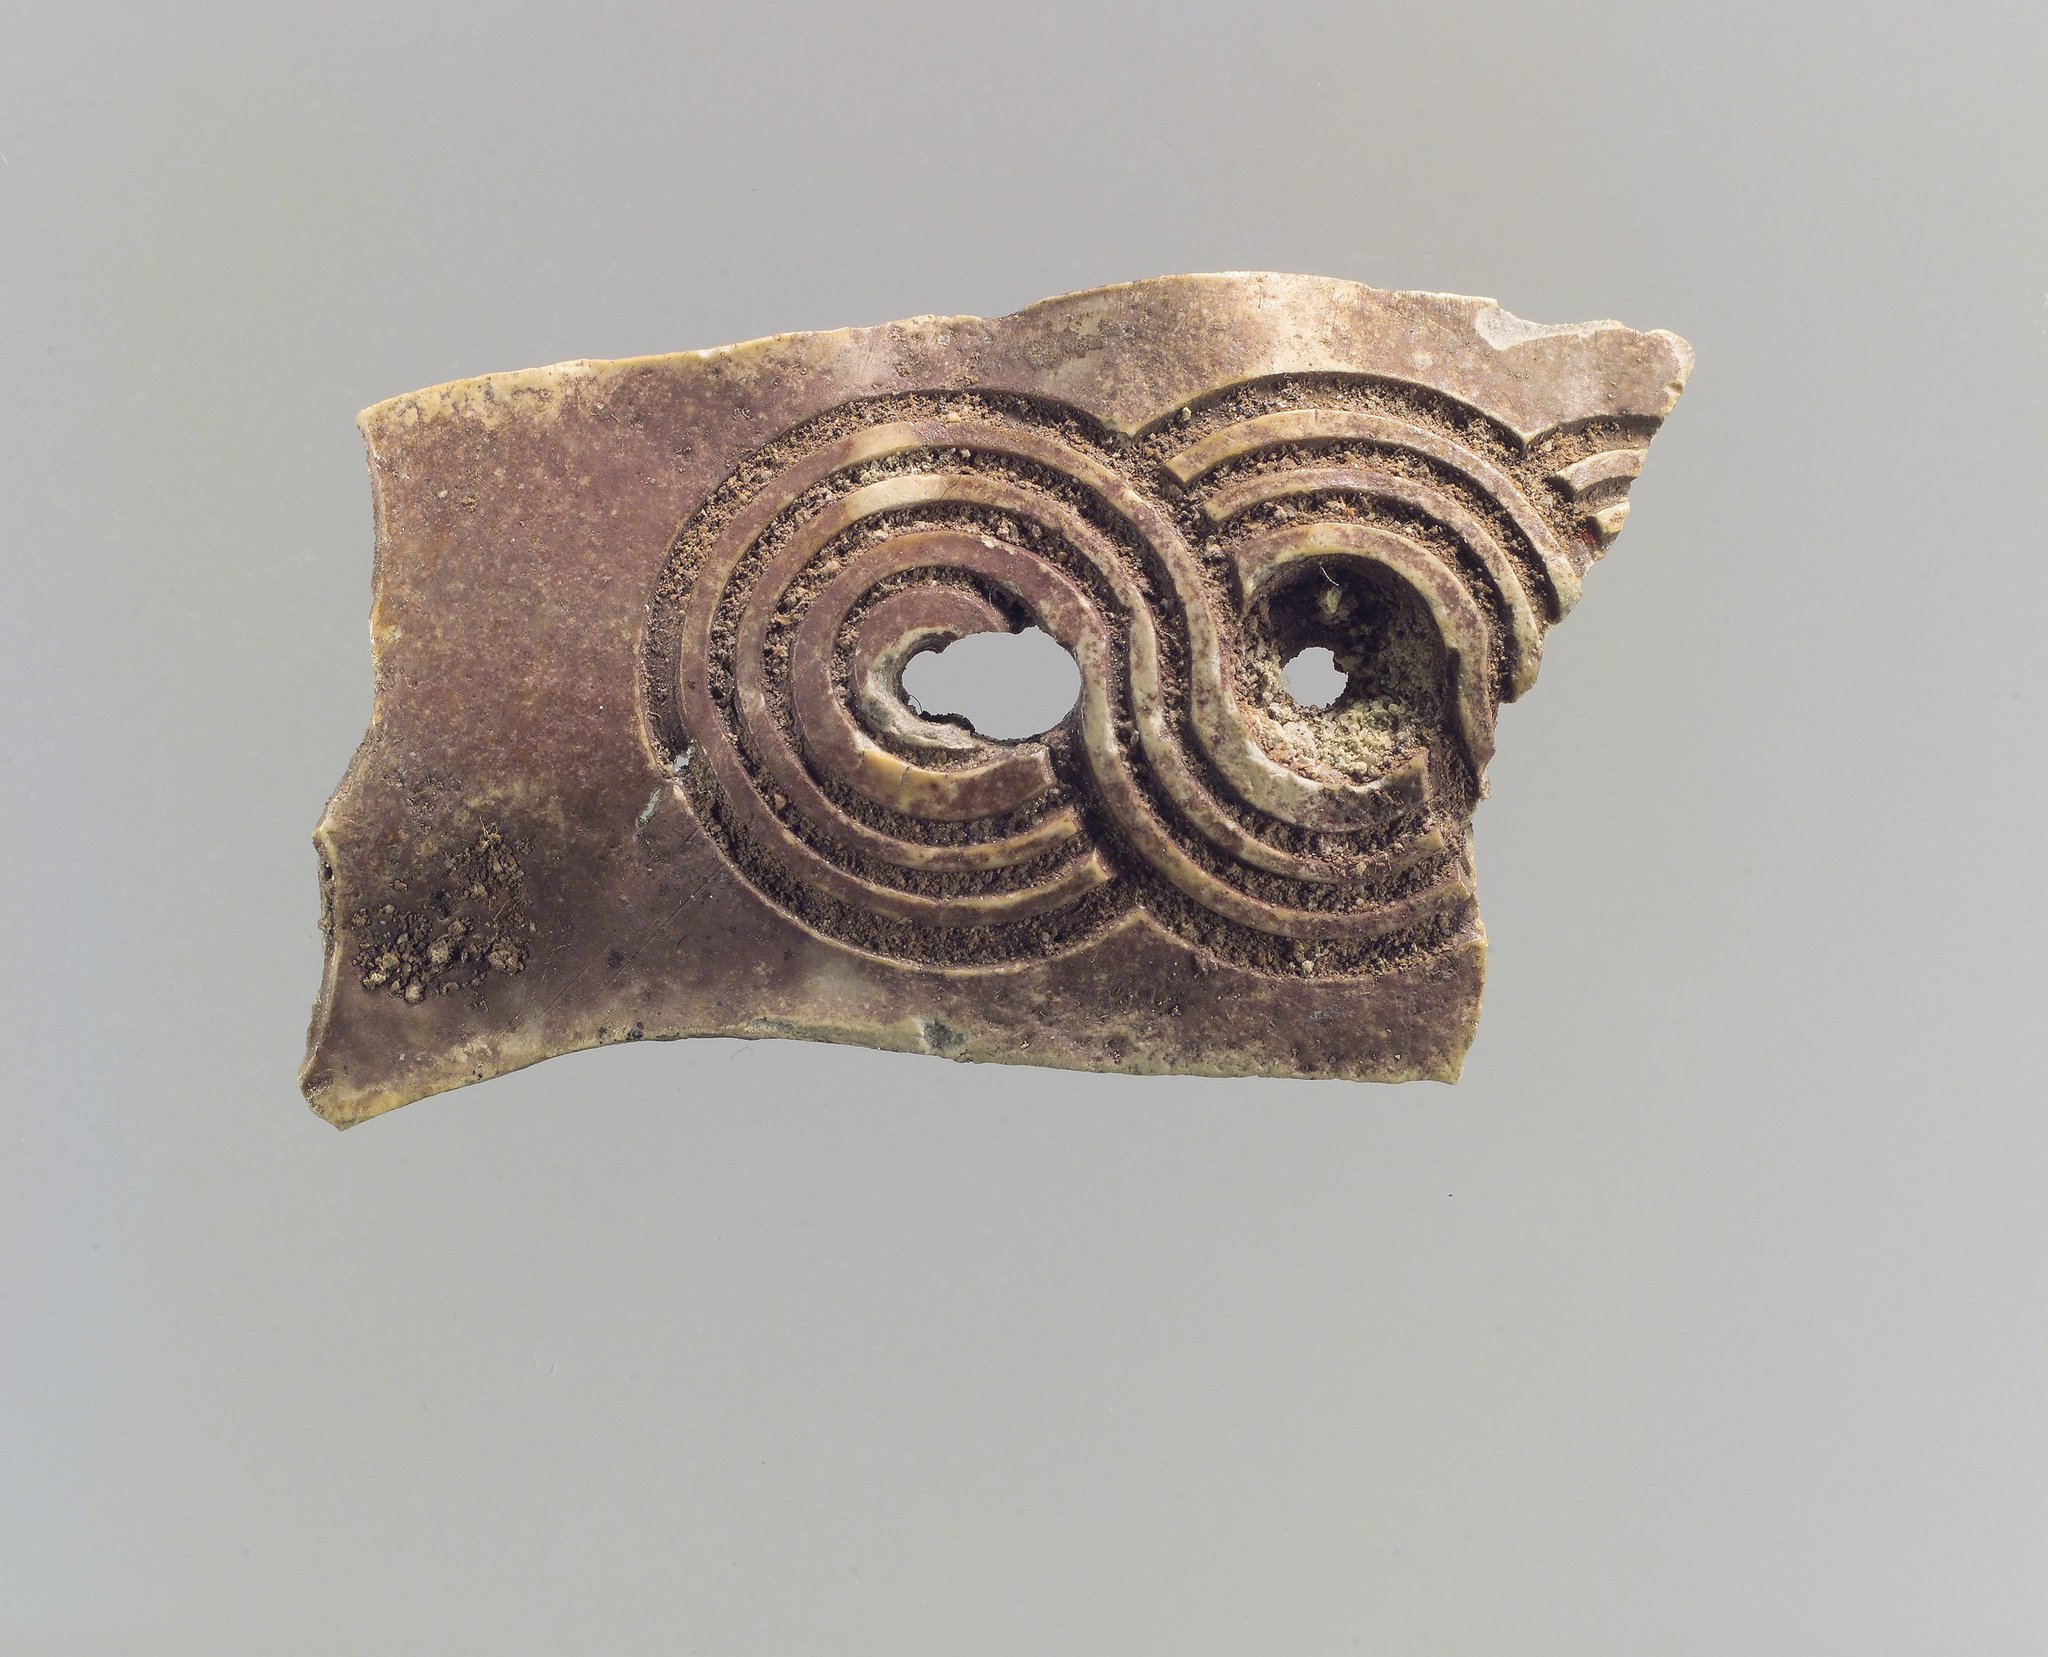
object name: plate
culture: assyrian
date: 1800-1701 BCE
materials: ivory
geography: anatolia